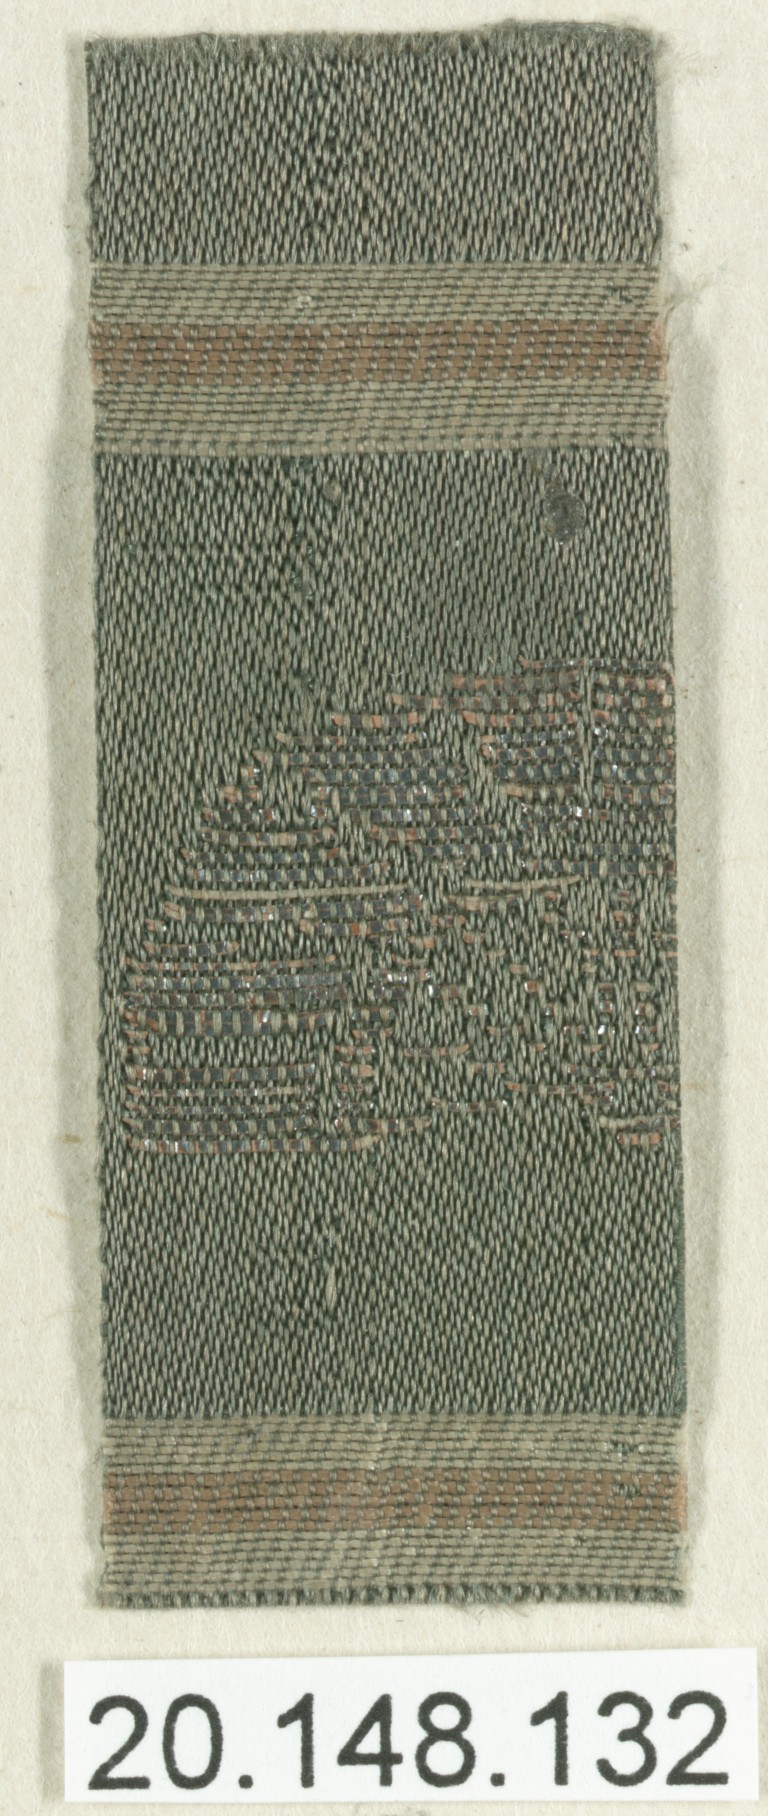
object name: textile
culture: chinese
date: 1501-1600